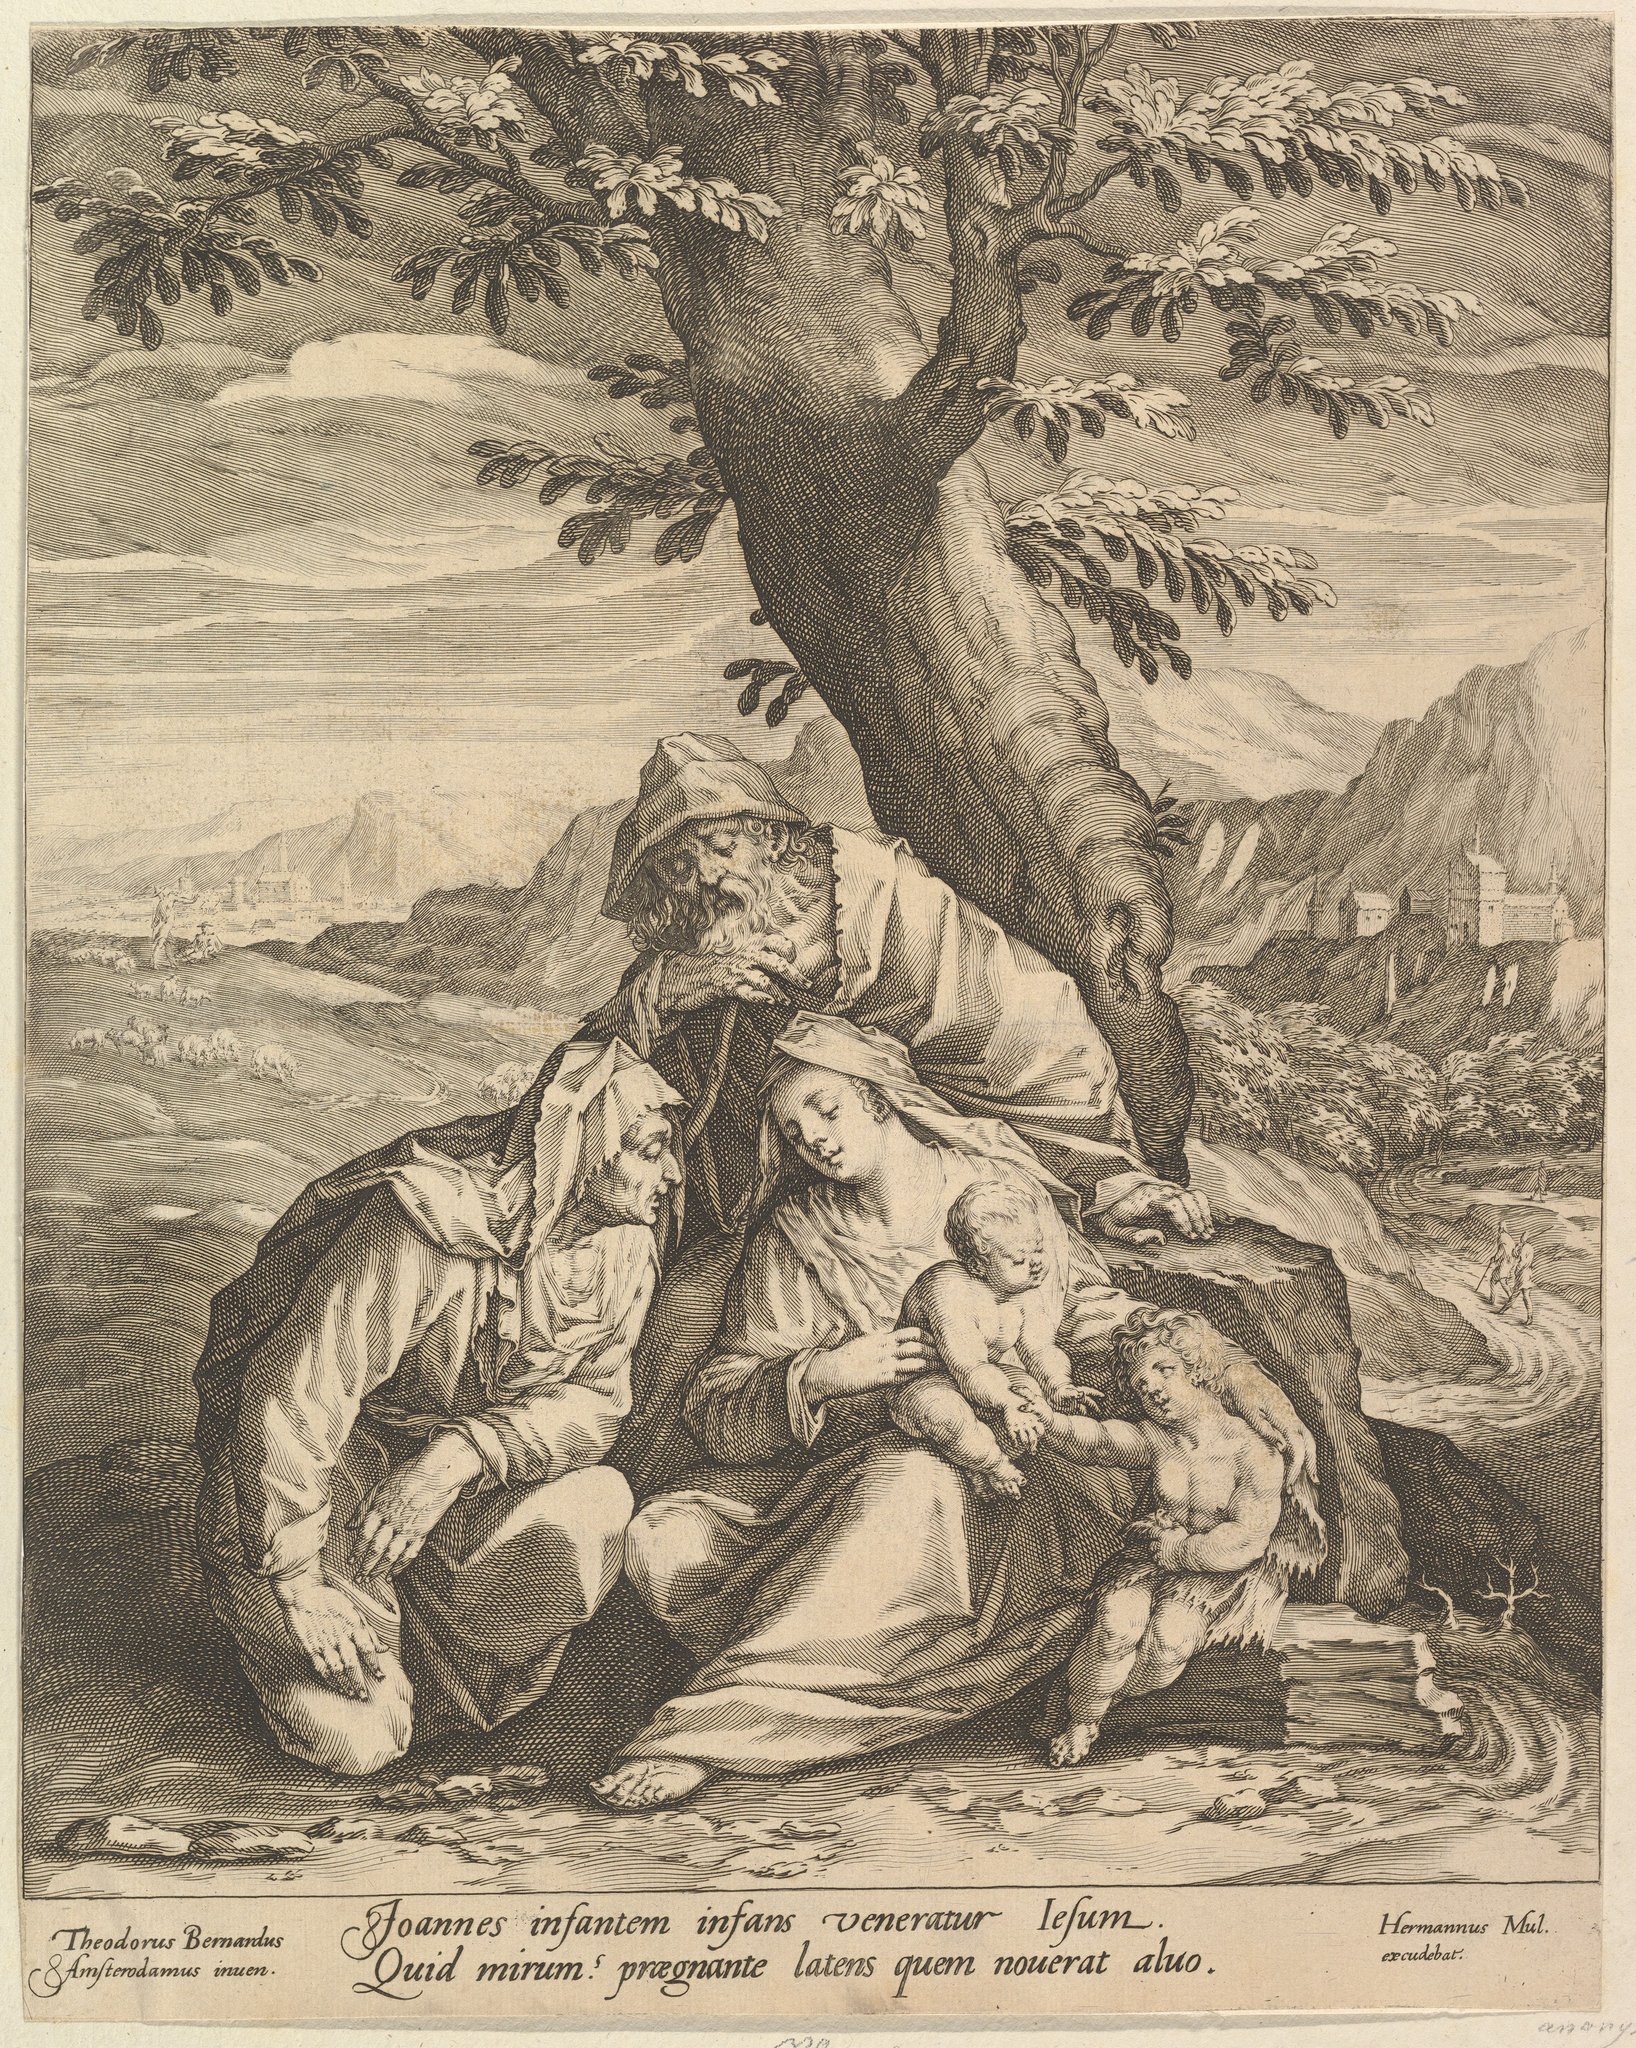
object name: print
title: Holy Family with St. Elizabeth and St. John the Baptist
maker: jan muller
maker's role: artist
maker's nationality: netherlandish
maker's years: 1571-1628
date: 1588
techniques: engraving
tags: trees,saint john the baptist,saints